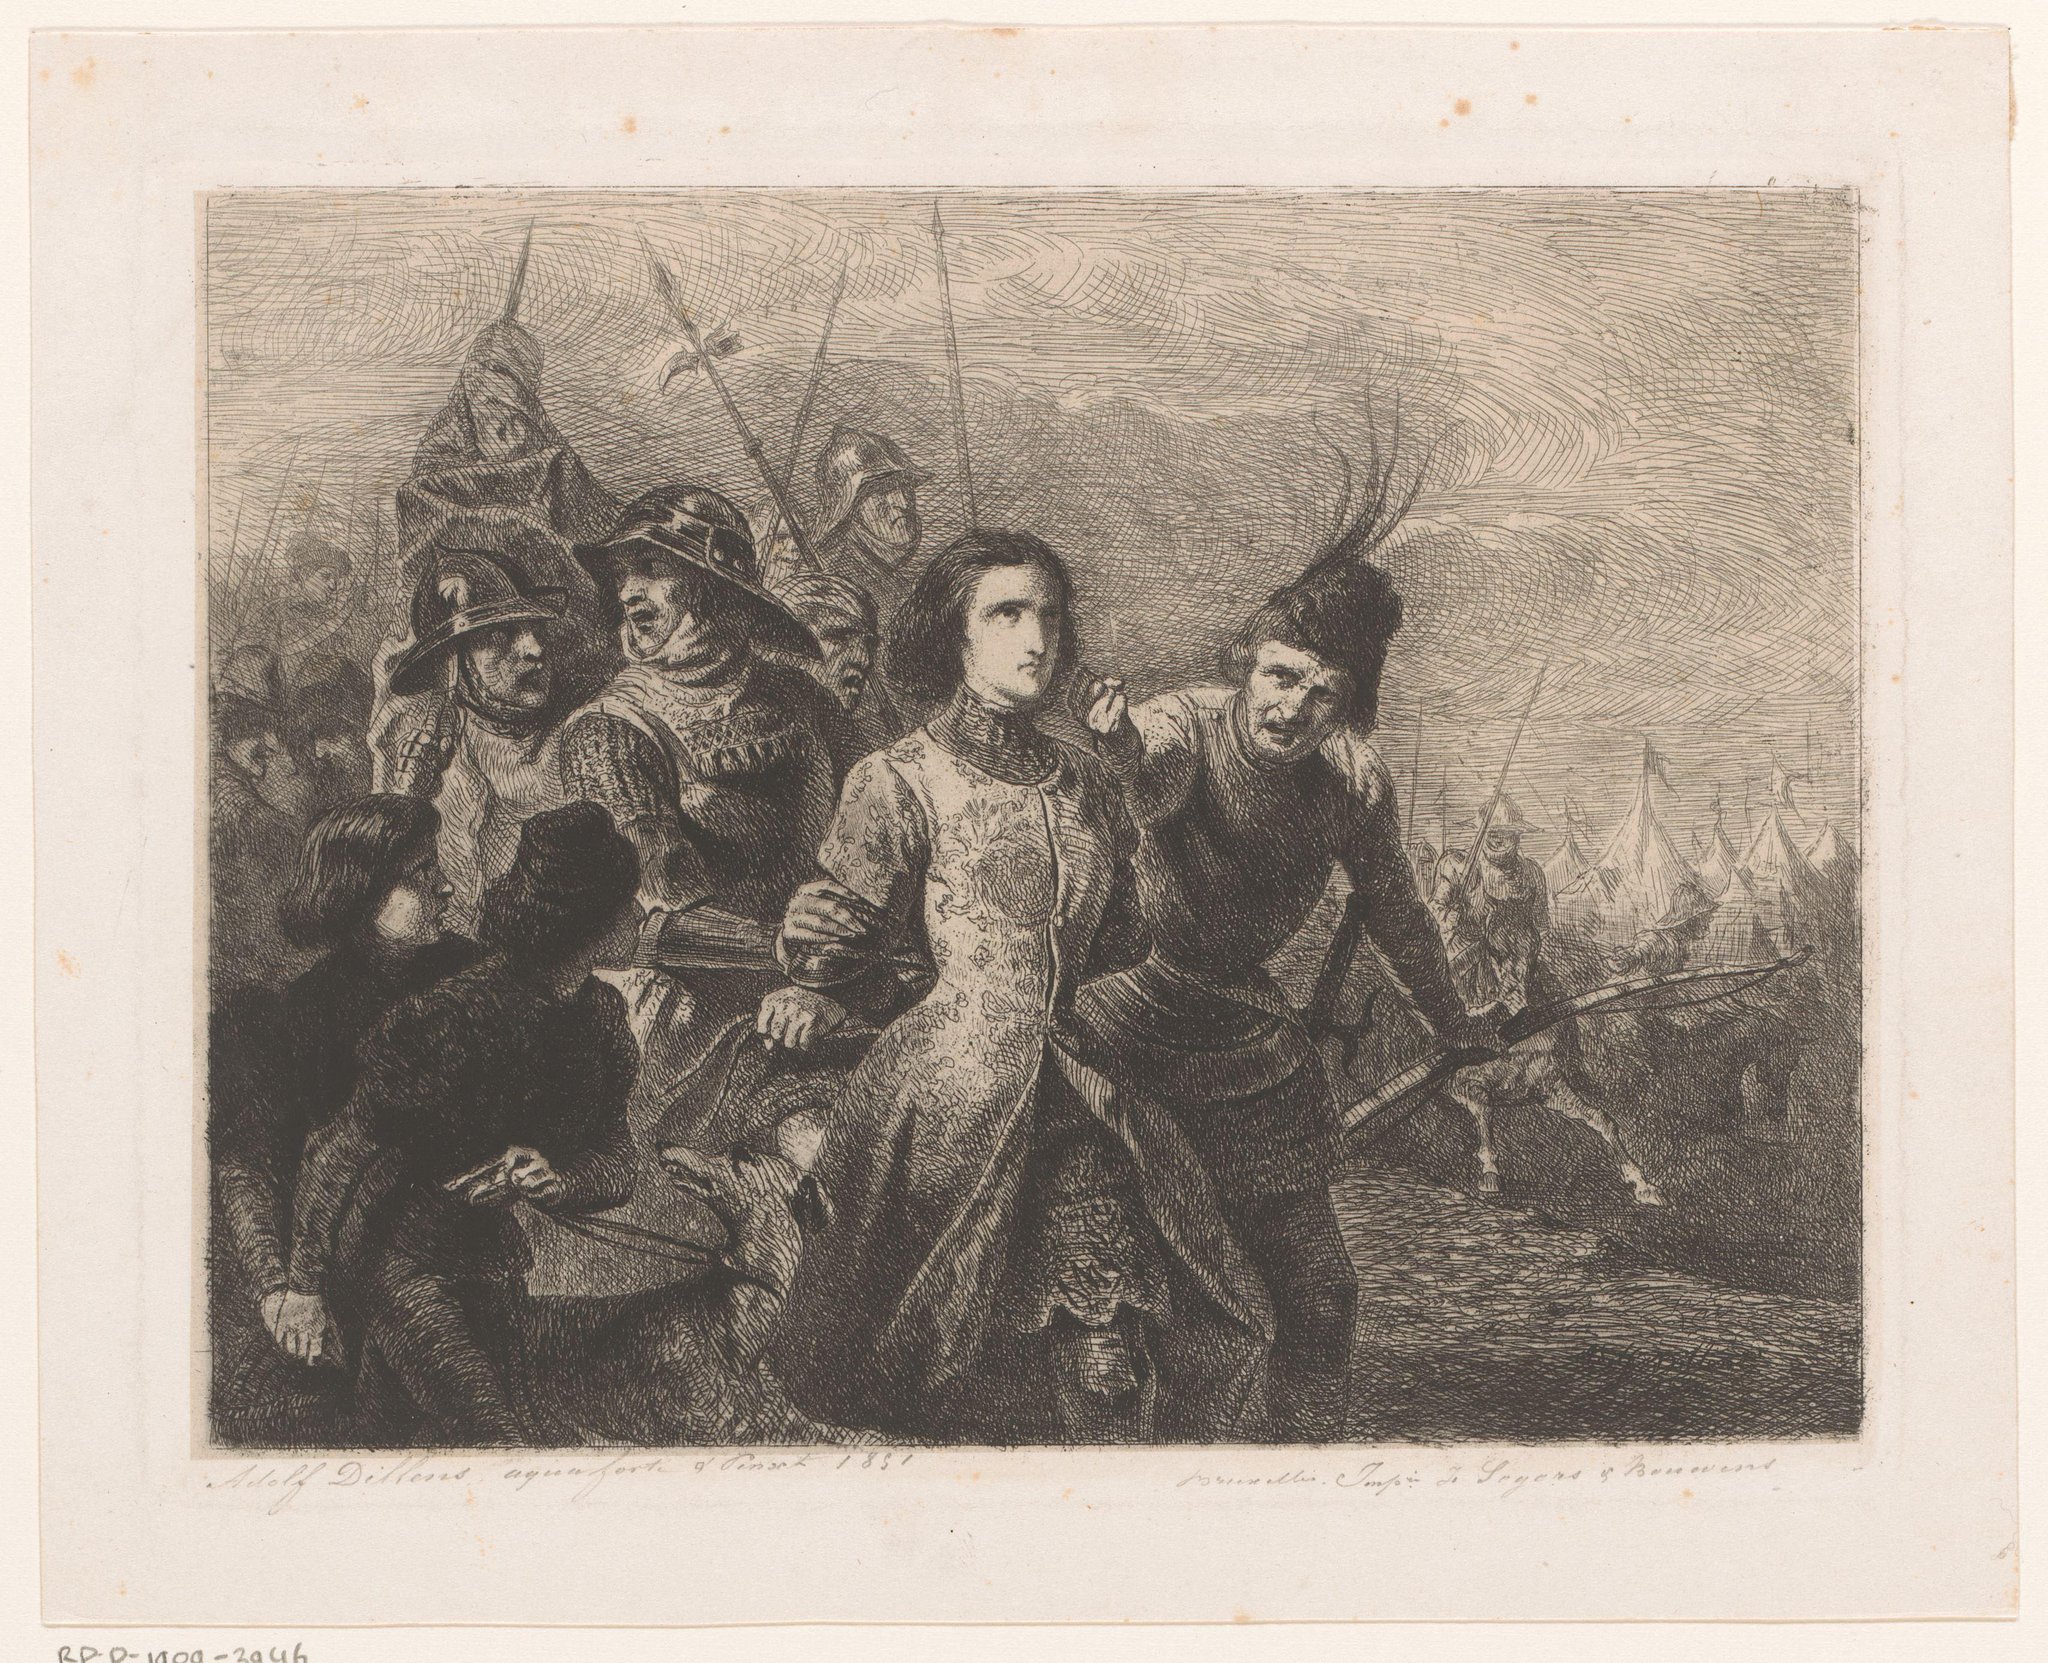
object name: print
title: Jeanne d'Arc wordt door soldaten gevangen en meegevoerd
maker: adolphe alexandre dillens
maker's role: draughtsman, painter, print maker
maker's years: 1821-1877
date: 1851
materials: paper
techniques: etching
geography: brussels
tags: joan of arc (jeanne d'arc); possible attributes: armour, banner, lance, sword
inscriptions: collector's mark: Lugt 2228